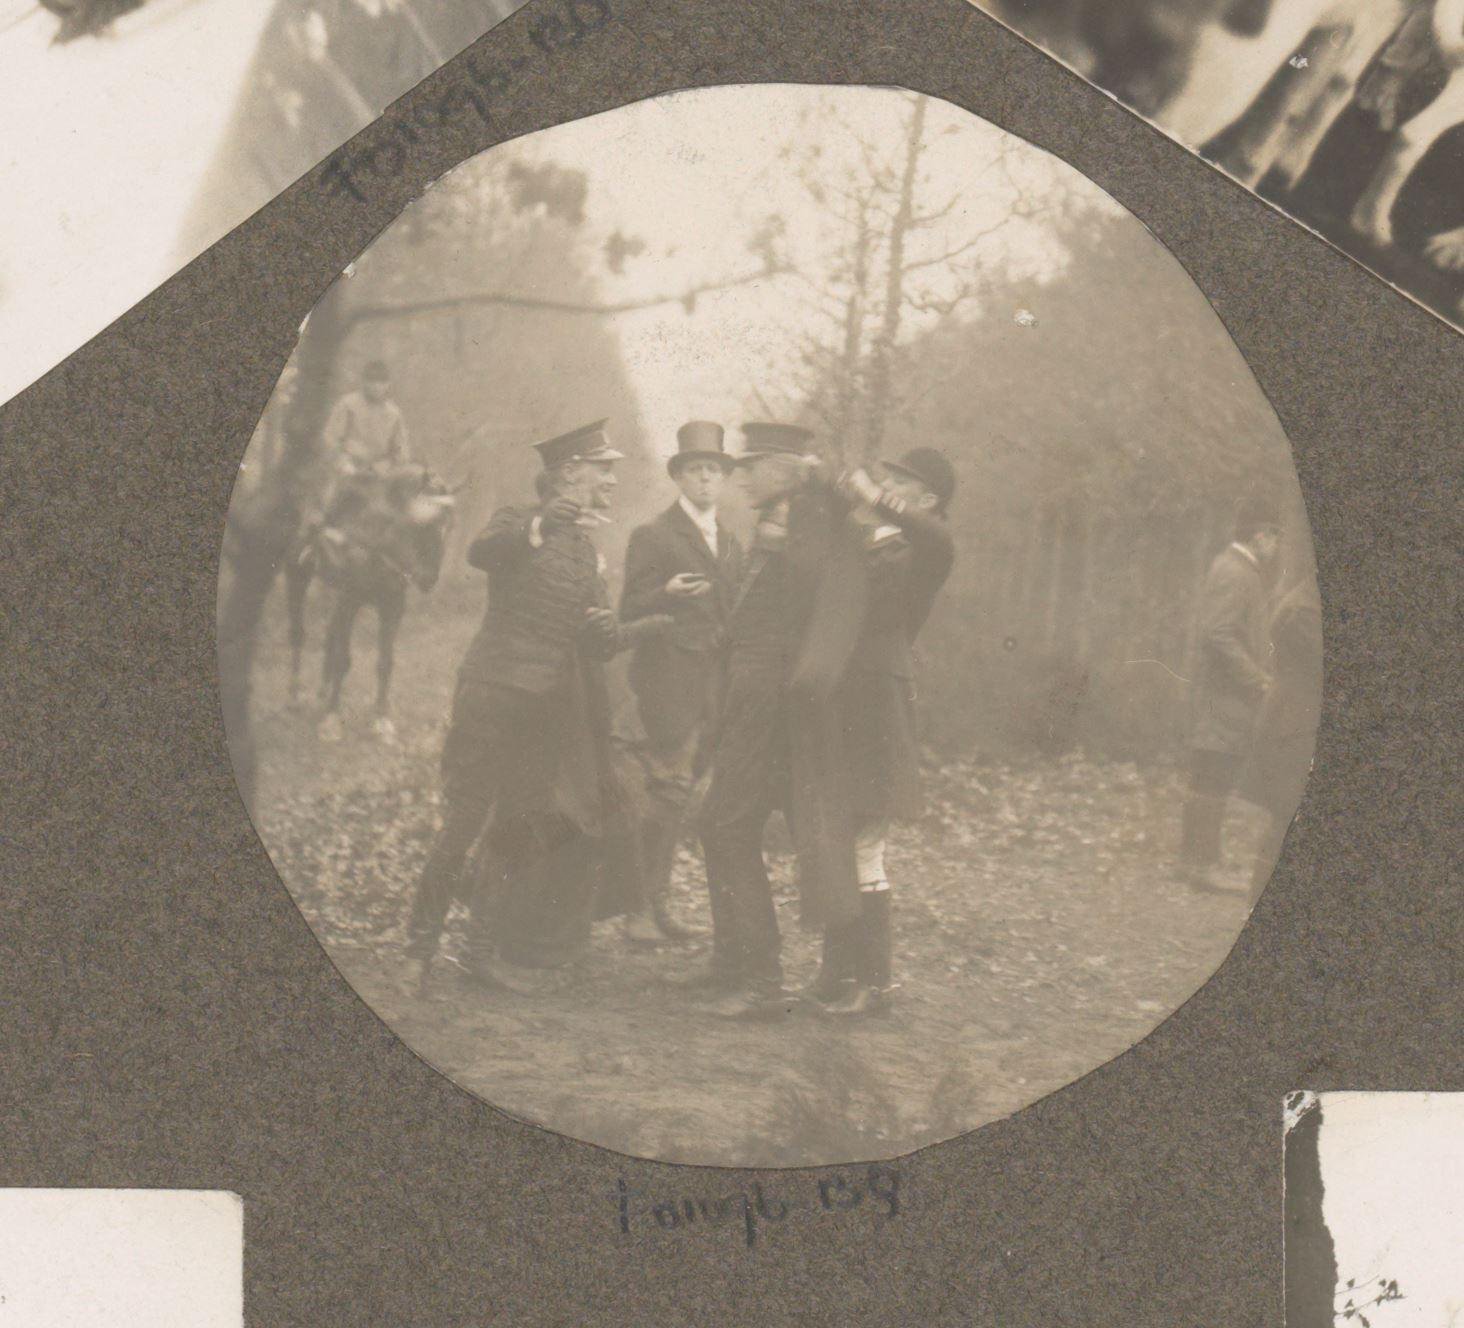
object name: photograph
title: Ruitertafereel op Koninklijke Houtvesterij Het Loo: ruiter wordt in zijn mantel geholpen in een bos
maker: Anonymous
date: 1900-1925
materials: photographic support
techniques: gelatin silver print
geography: het loo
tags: riding a horse, ass, or mule; rider, horseman, hunting, chase, hunting-ground, dressing someone else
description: Onderdeel van Fotoalbum van de heer Brams, opperhoutvester van koningin Wilhelmina op Koninklijke Houtvesterij Het Loo.